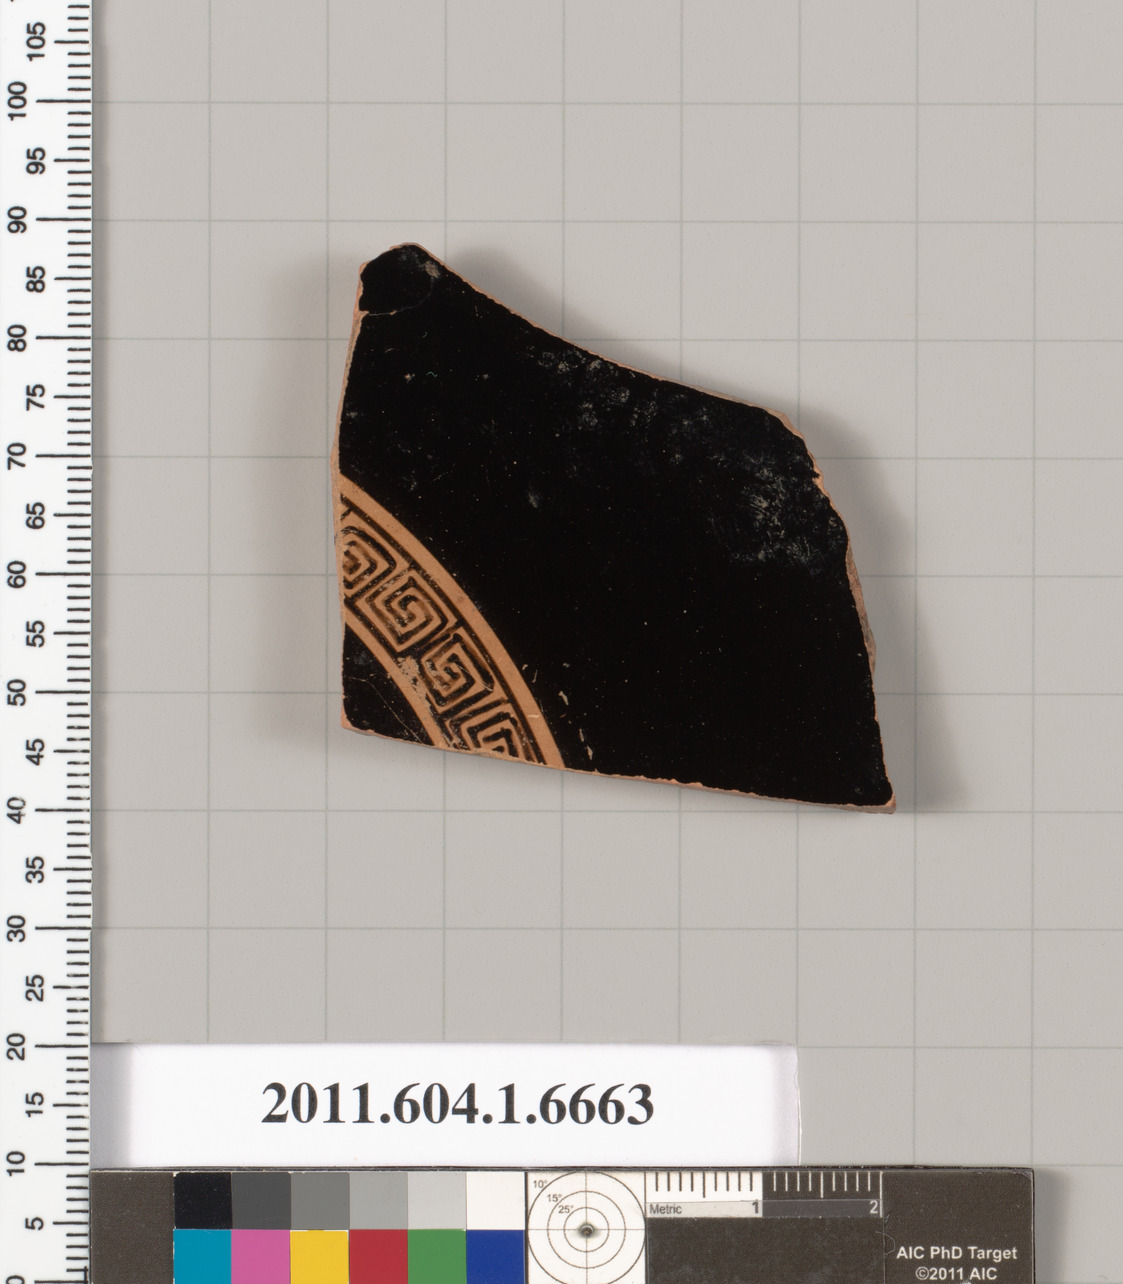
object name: kylix fragment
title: Terracotta fragment of a kylix (drinking cup)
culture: greek, attic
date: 490-470 BCE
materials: terracotta